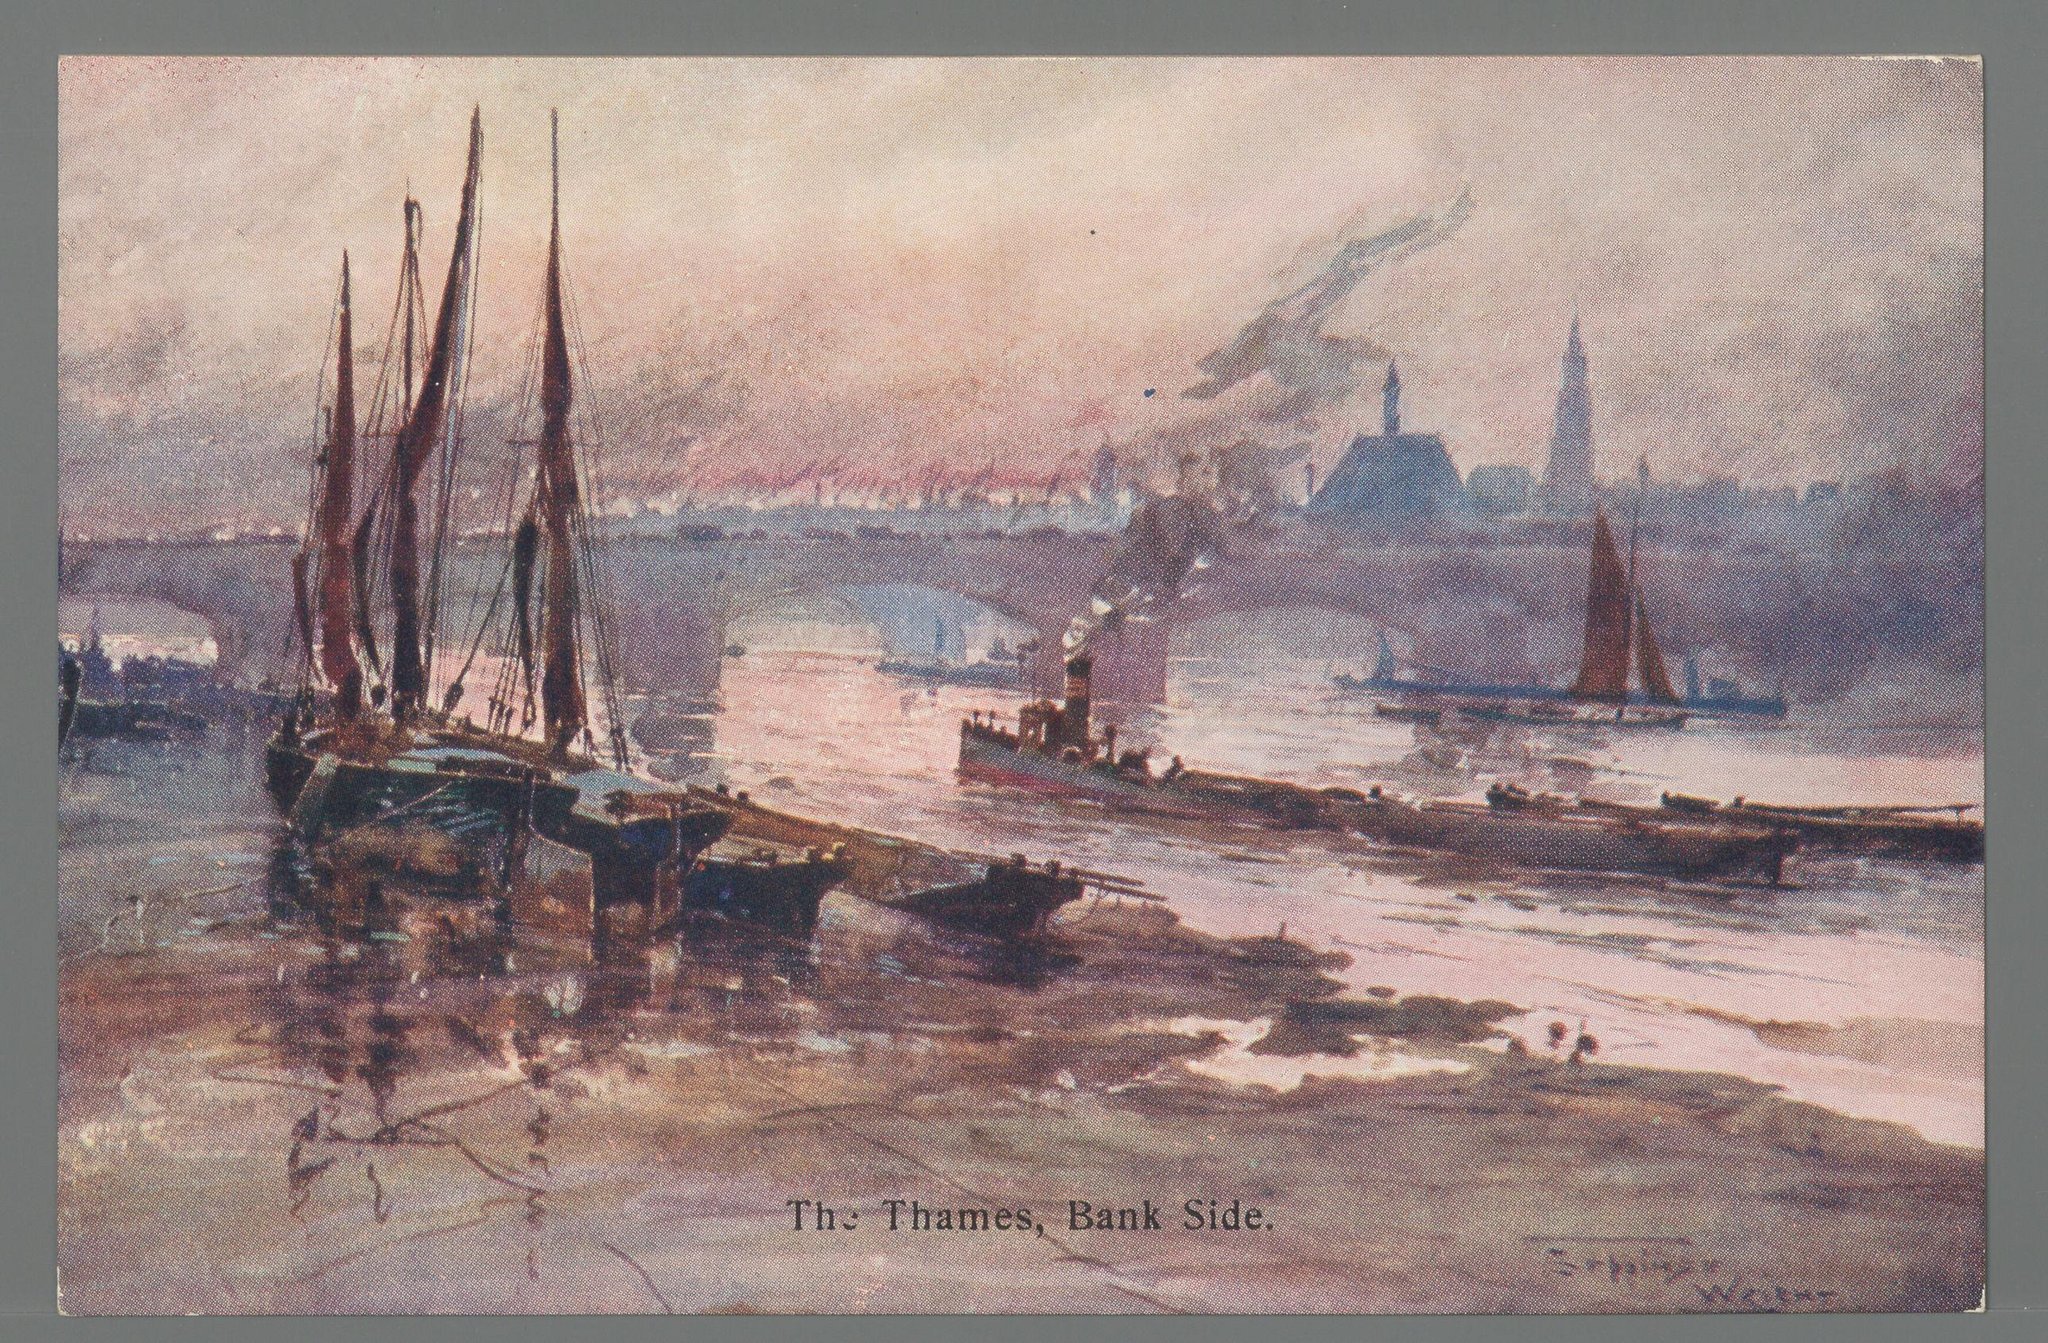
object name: photomechanical print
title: The Thames, Bank Side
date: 1902-1940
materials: cardboard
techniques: color autotype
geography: london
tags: ships (in general), canals, waters (in city), bridge in city across river, canal, etc., thames